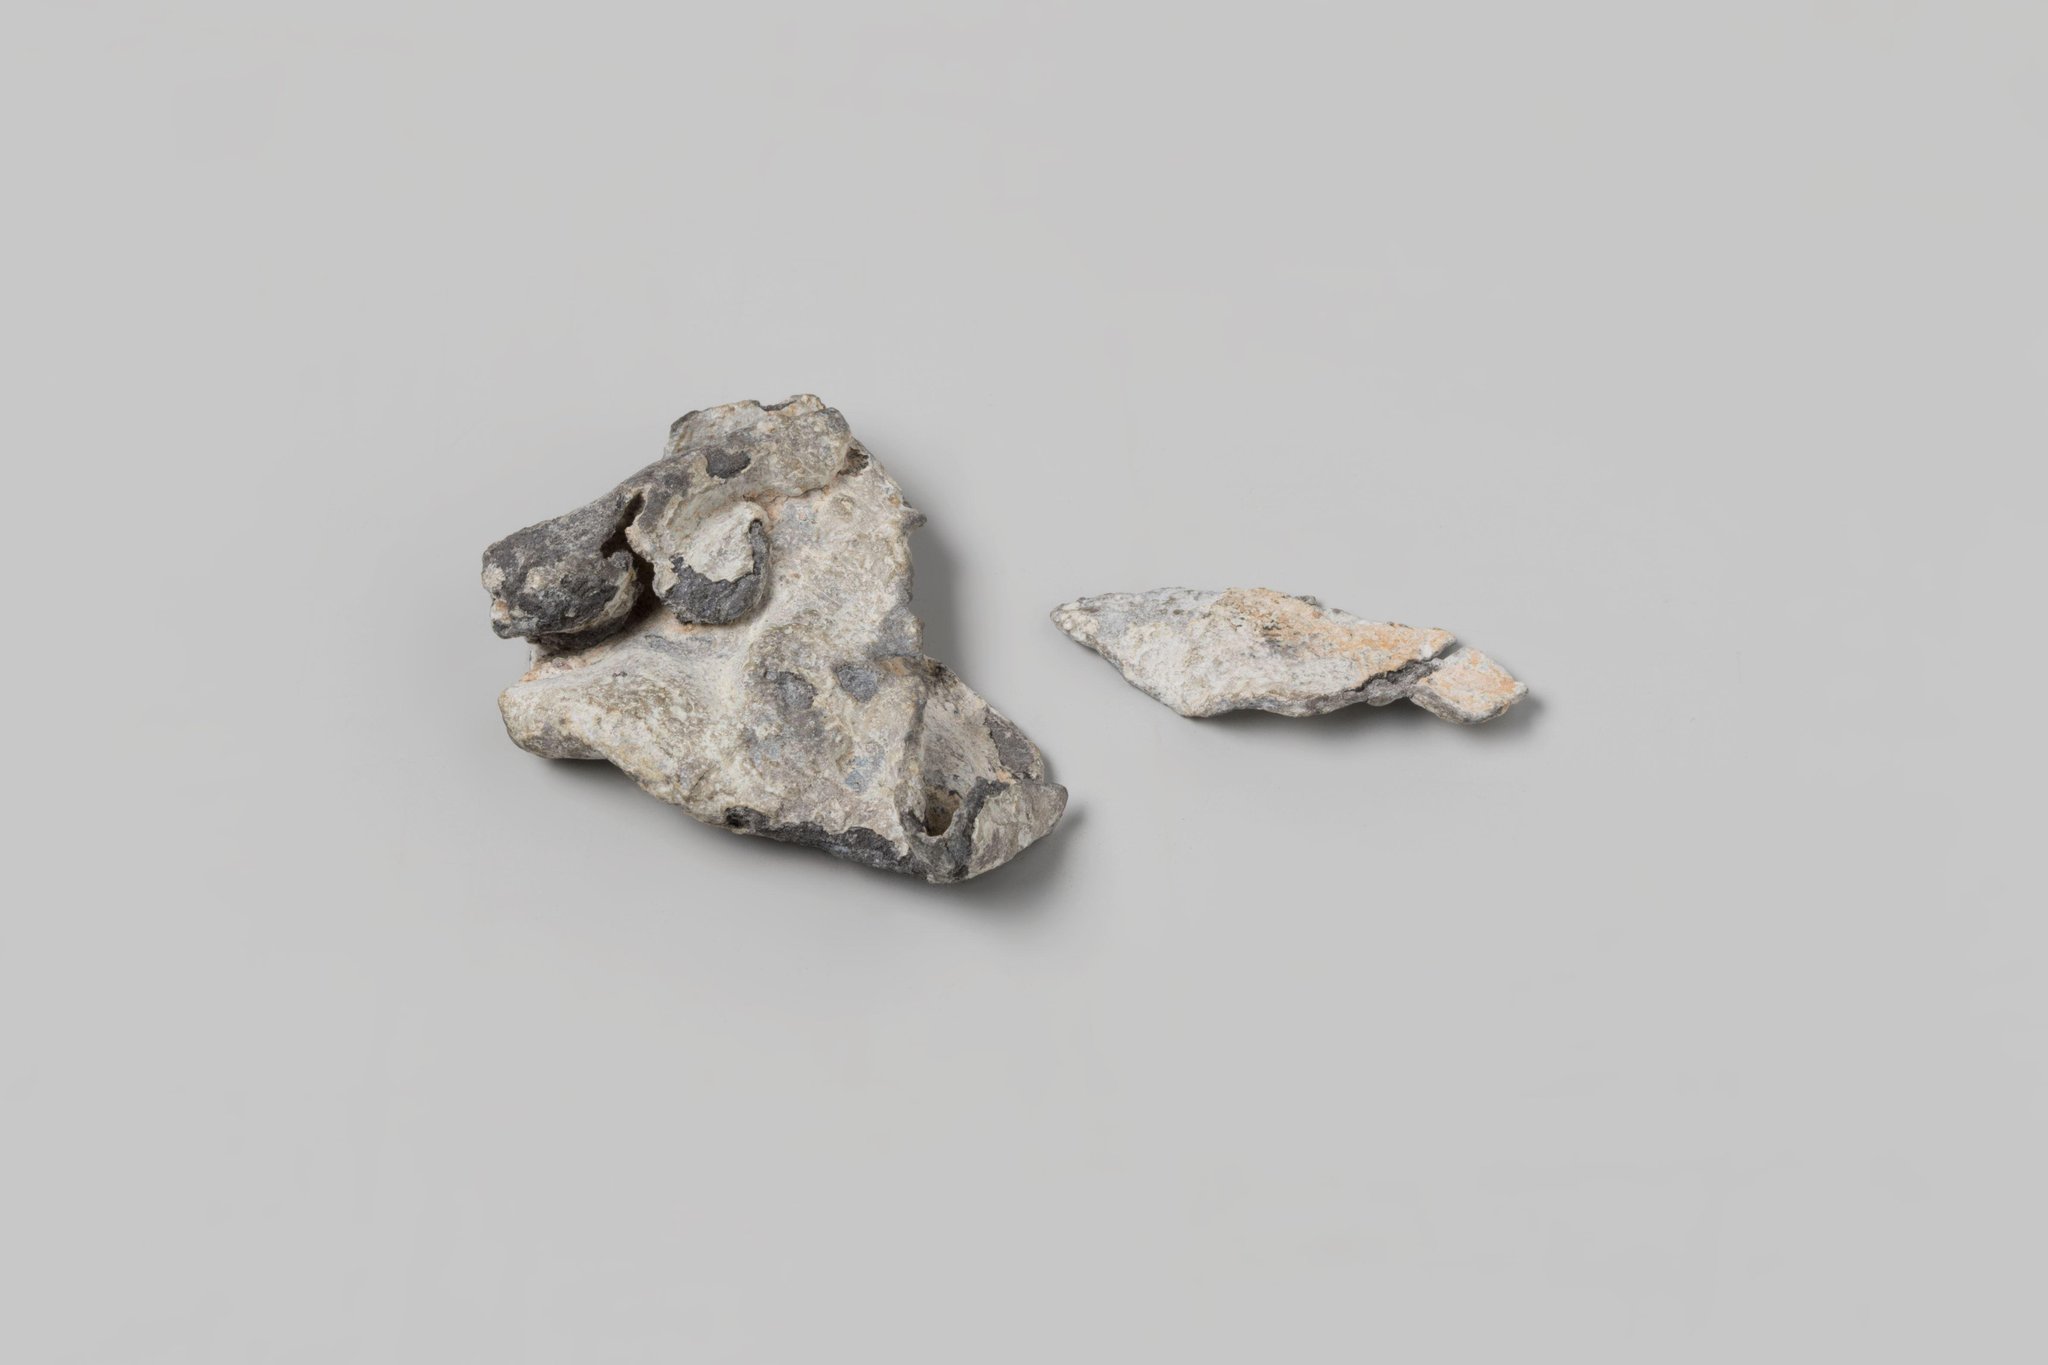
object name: fragment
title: Fragment lood uit het wrak van de Oost-Indiëvaarder Hollandia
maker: Anonymous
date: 1700-1743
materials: lead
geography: netherlands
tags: verenigde oostindische compagnie, hollandia (schip), annet